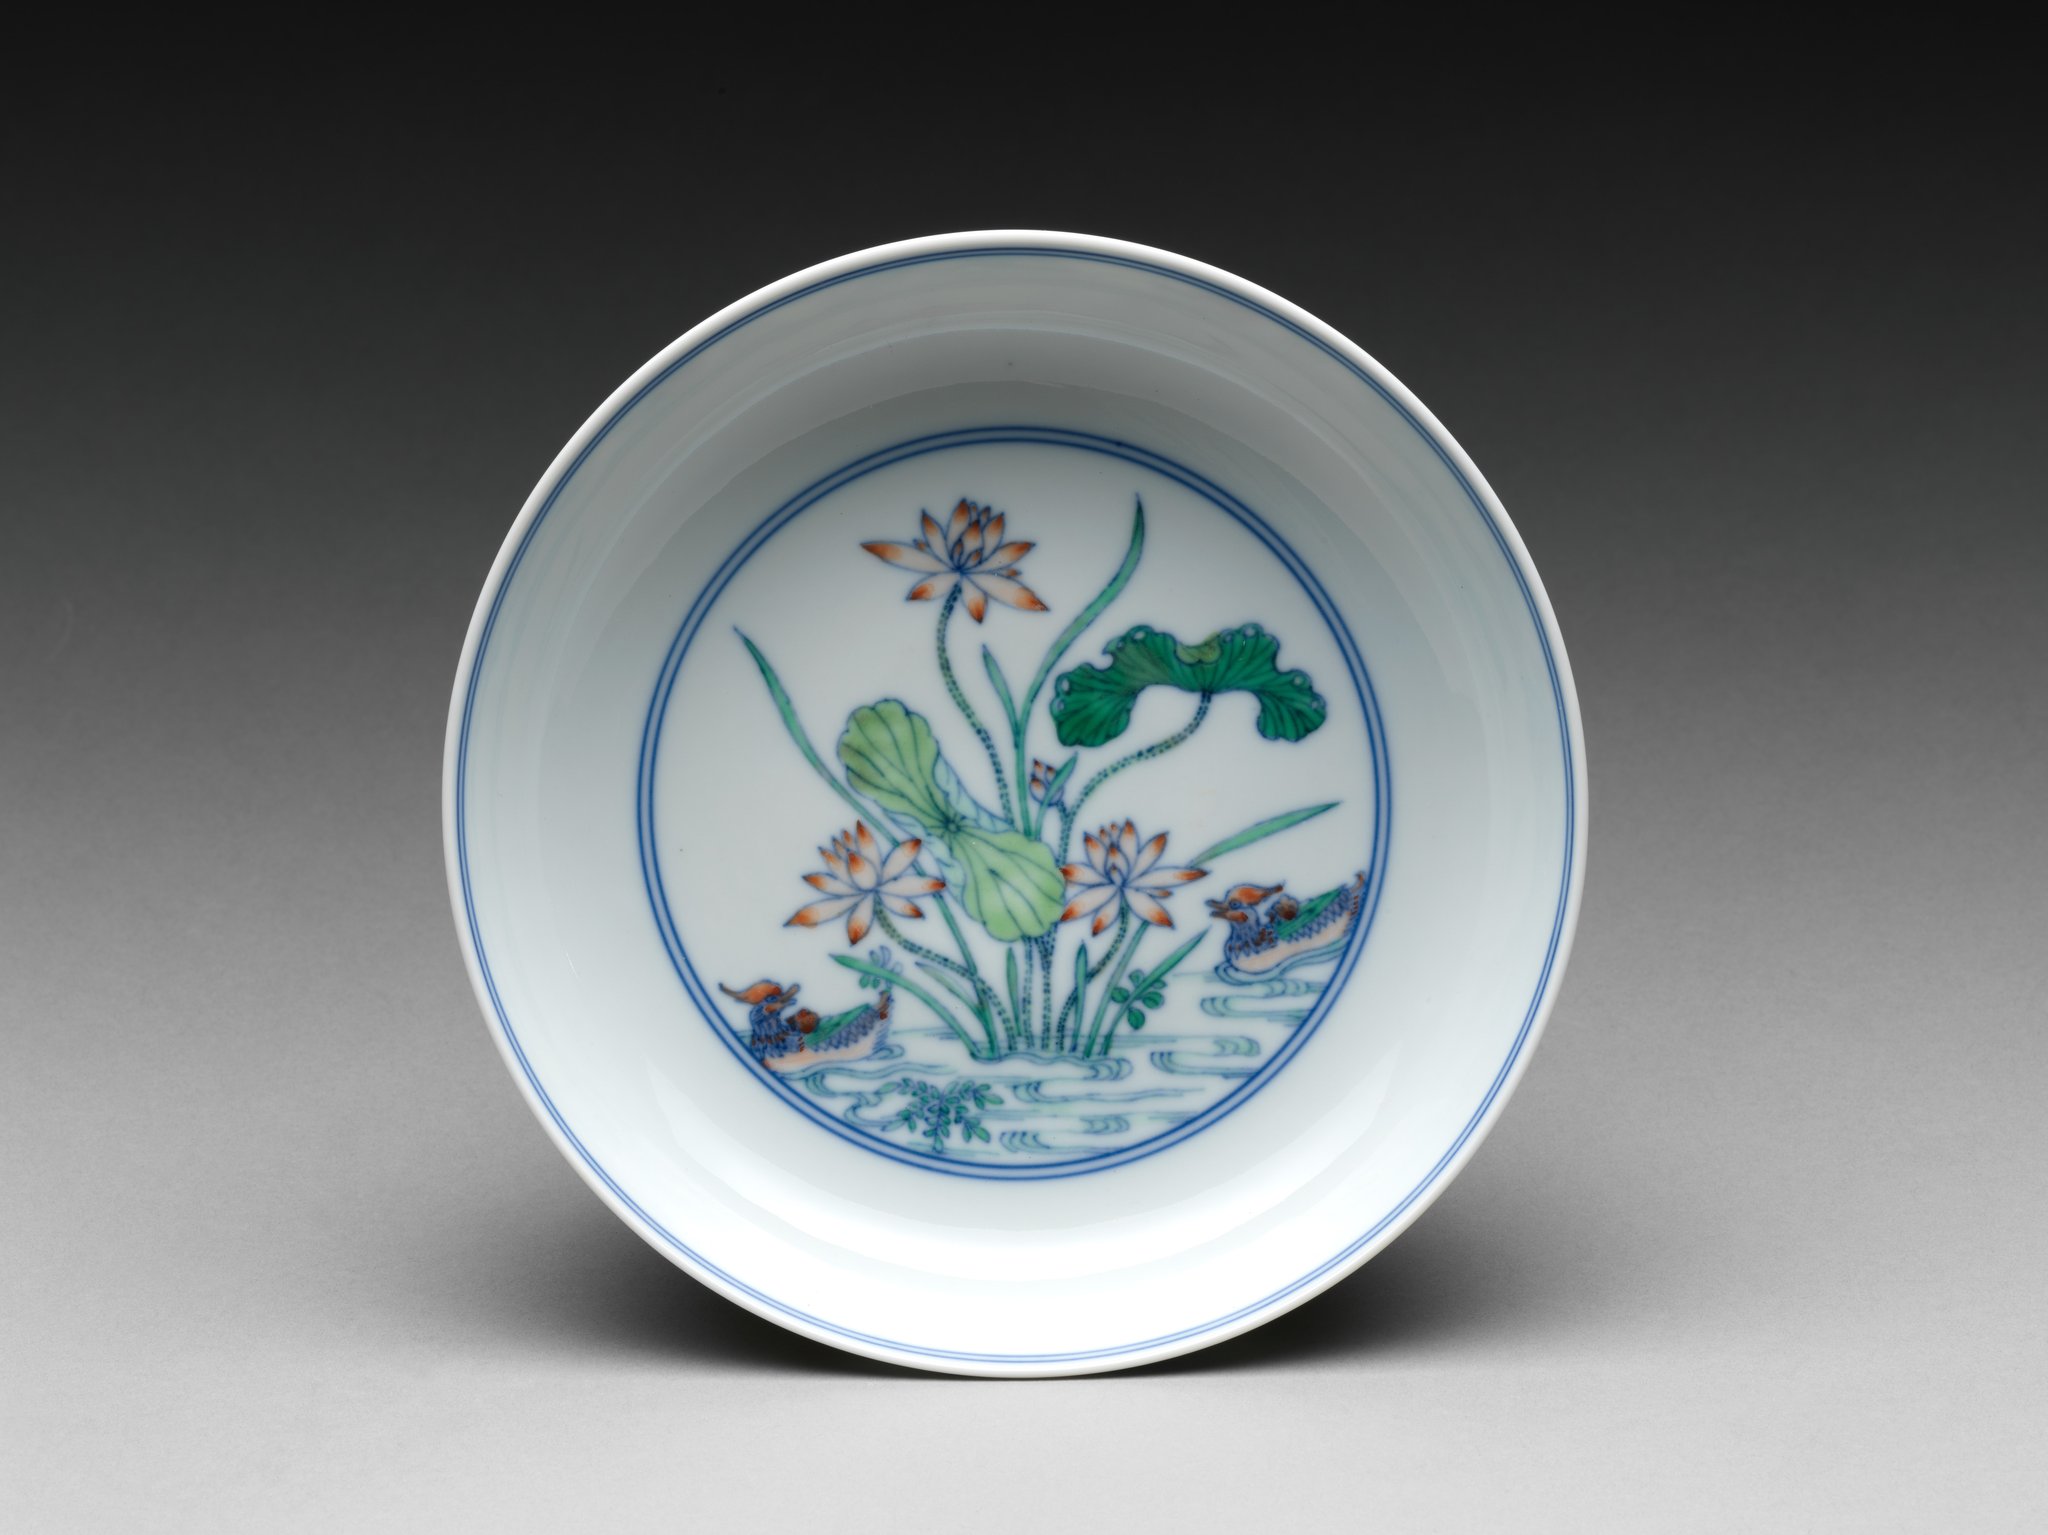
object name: dish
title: Dish with Lotus Pond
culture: chinese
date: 1701-1733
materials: cobalt, enamel, glaze, porcelain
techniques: painting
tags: lotuses